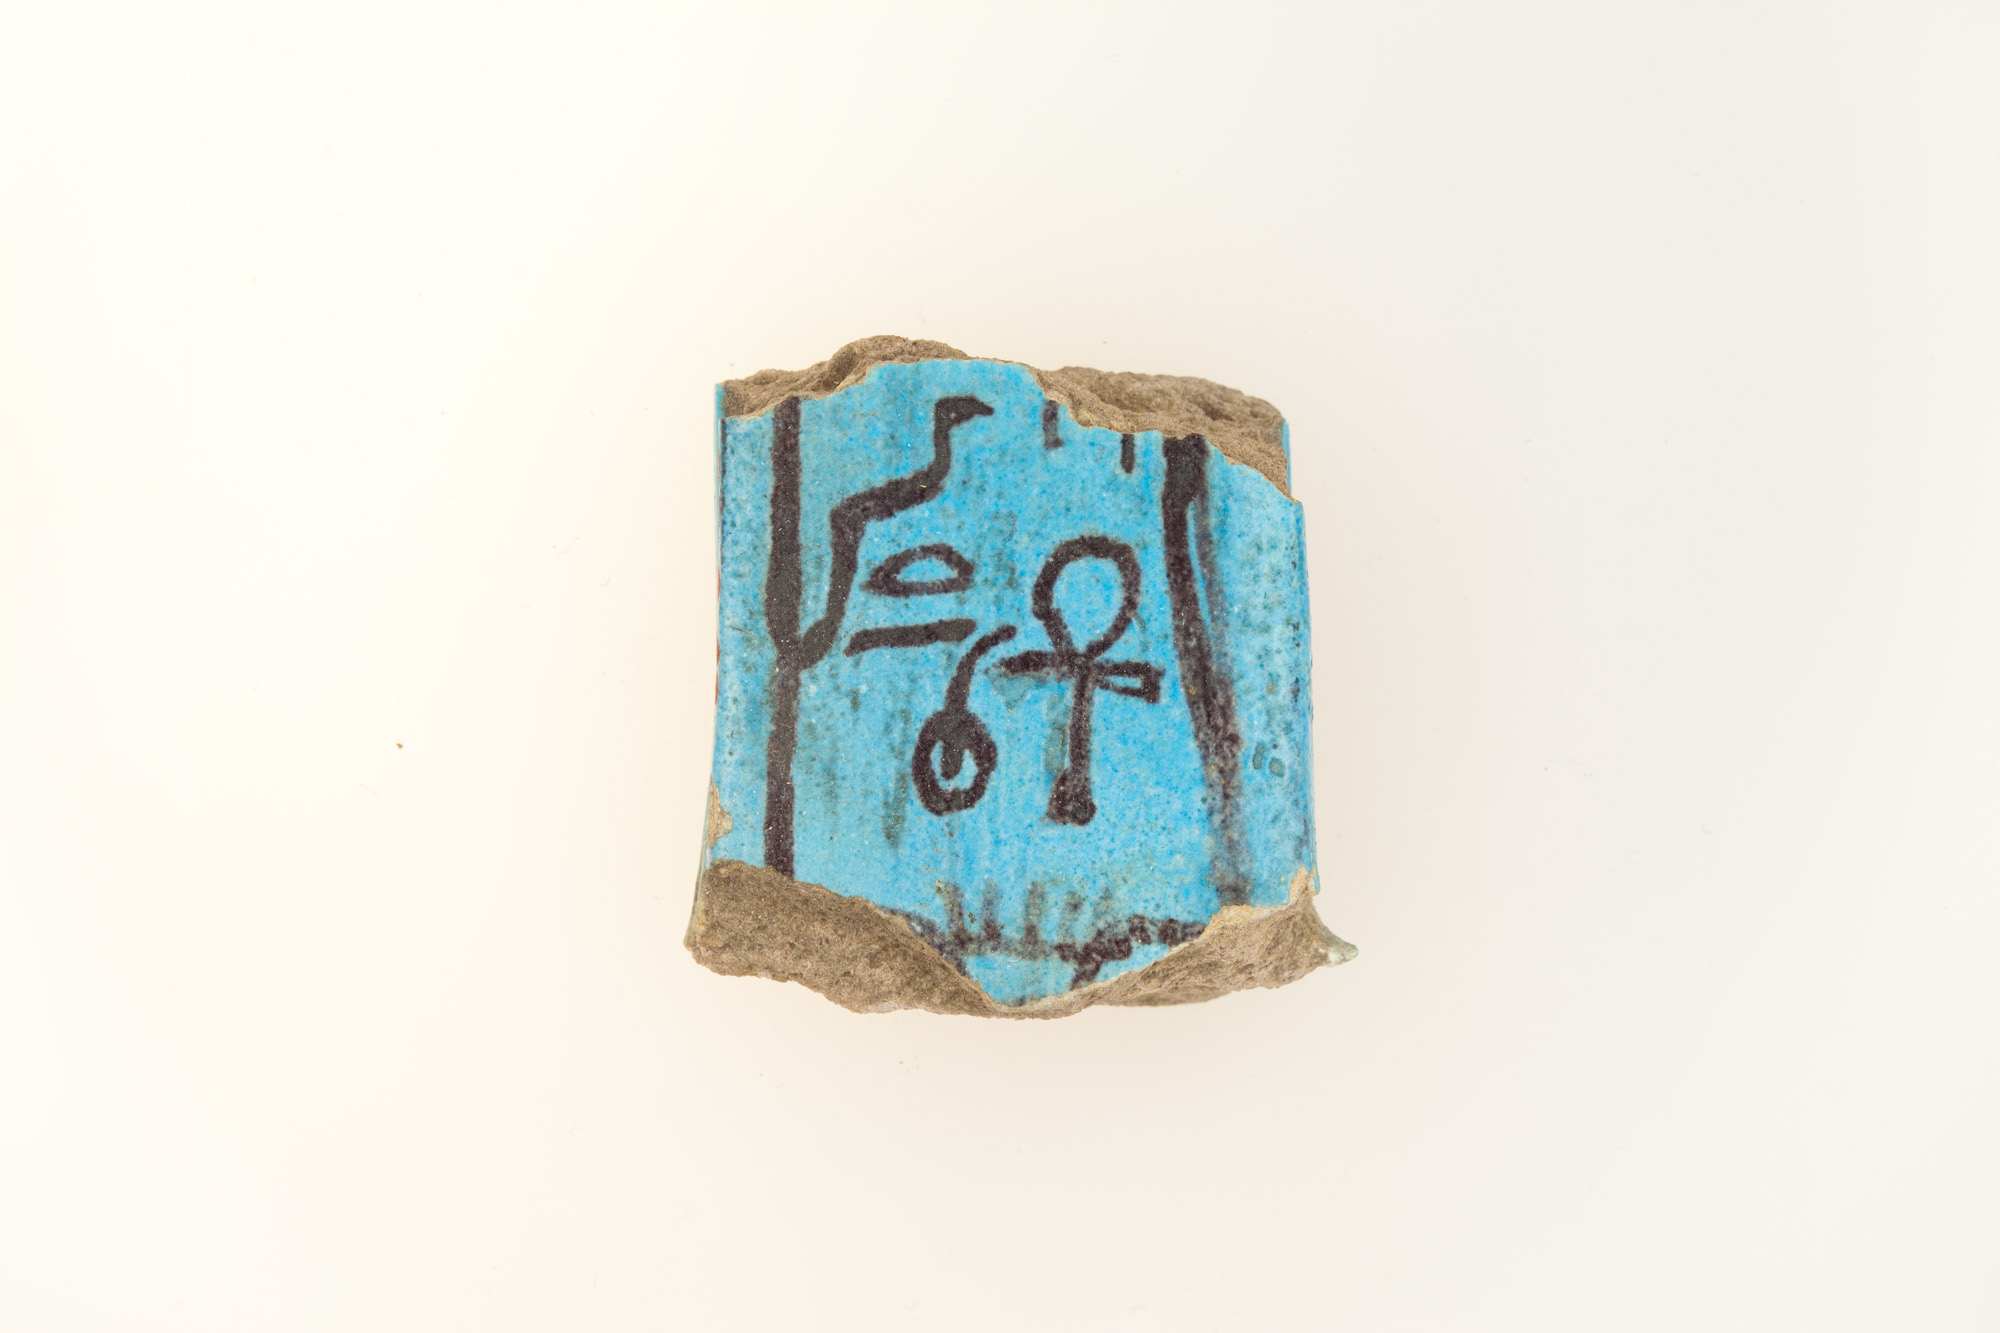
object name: menat fragment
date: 1479-1458 BCE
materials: faience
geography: egypt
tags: hieroglyphs